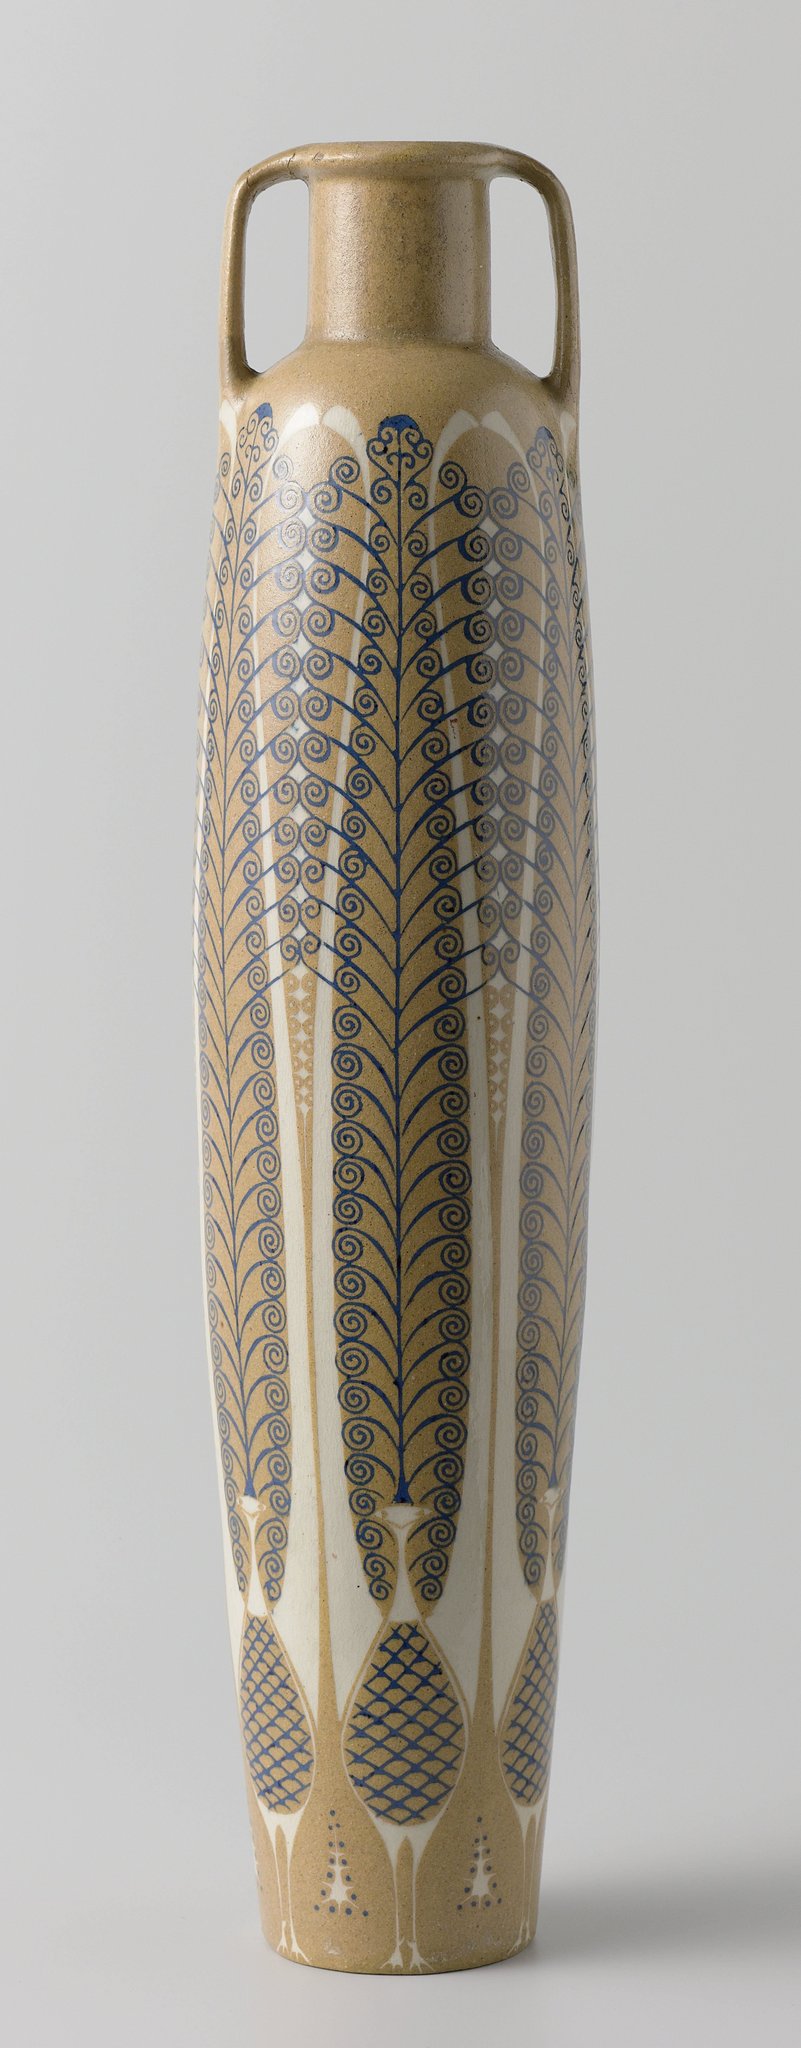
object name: vase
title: Cilindervormige vaas met gestileerde liervogels in wit en blauw op geelbruine fond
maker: chris van der hoef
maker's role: ceramicist, draughtsman, sculptor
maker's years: 1875-1933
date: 1902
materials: earthenware, glaze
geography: amsterdam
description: Vase. Earthenware. Ouder-Amstel, Amstelhoek, c. 1900 - 1903, after a design by Christiaan J. van der Hoef. Factory under the direction of L. Zijl. Given by the Commissie voor Fotoverkoop, 1970.